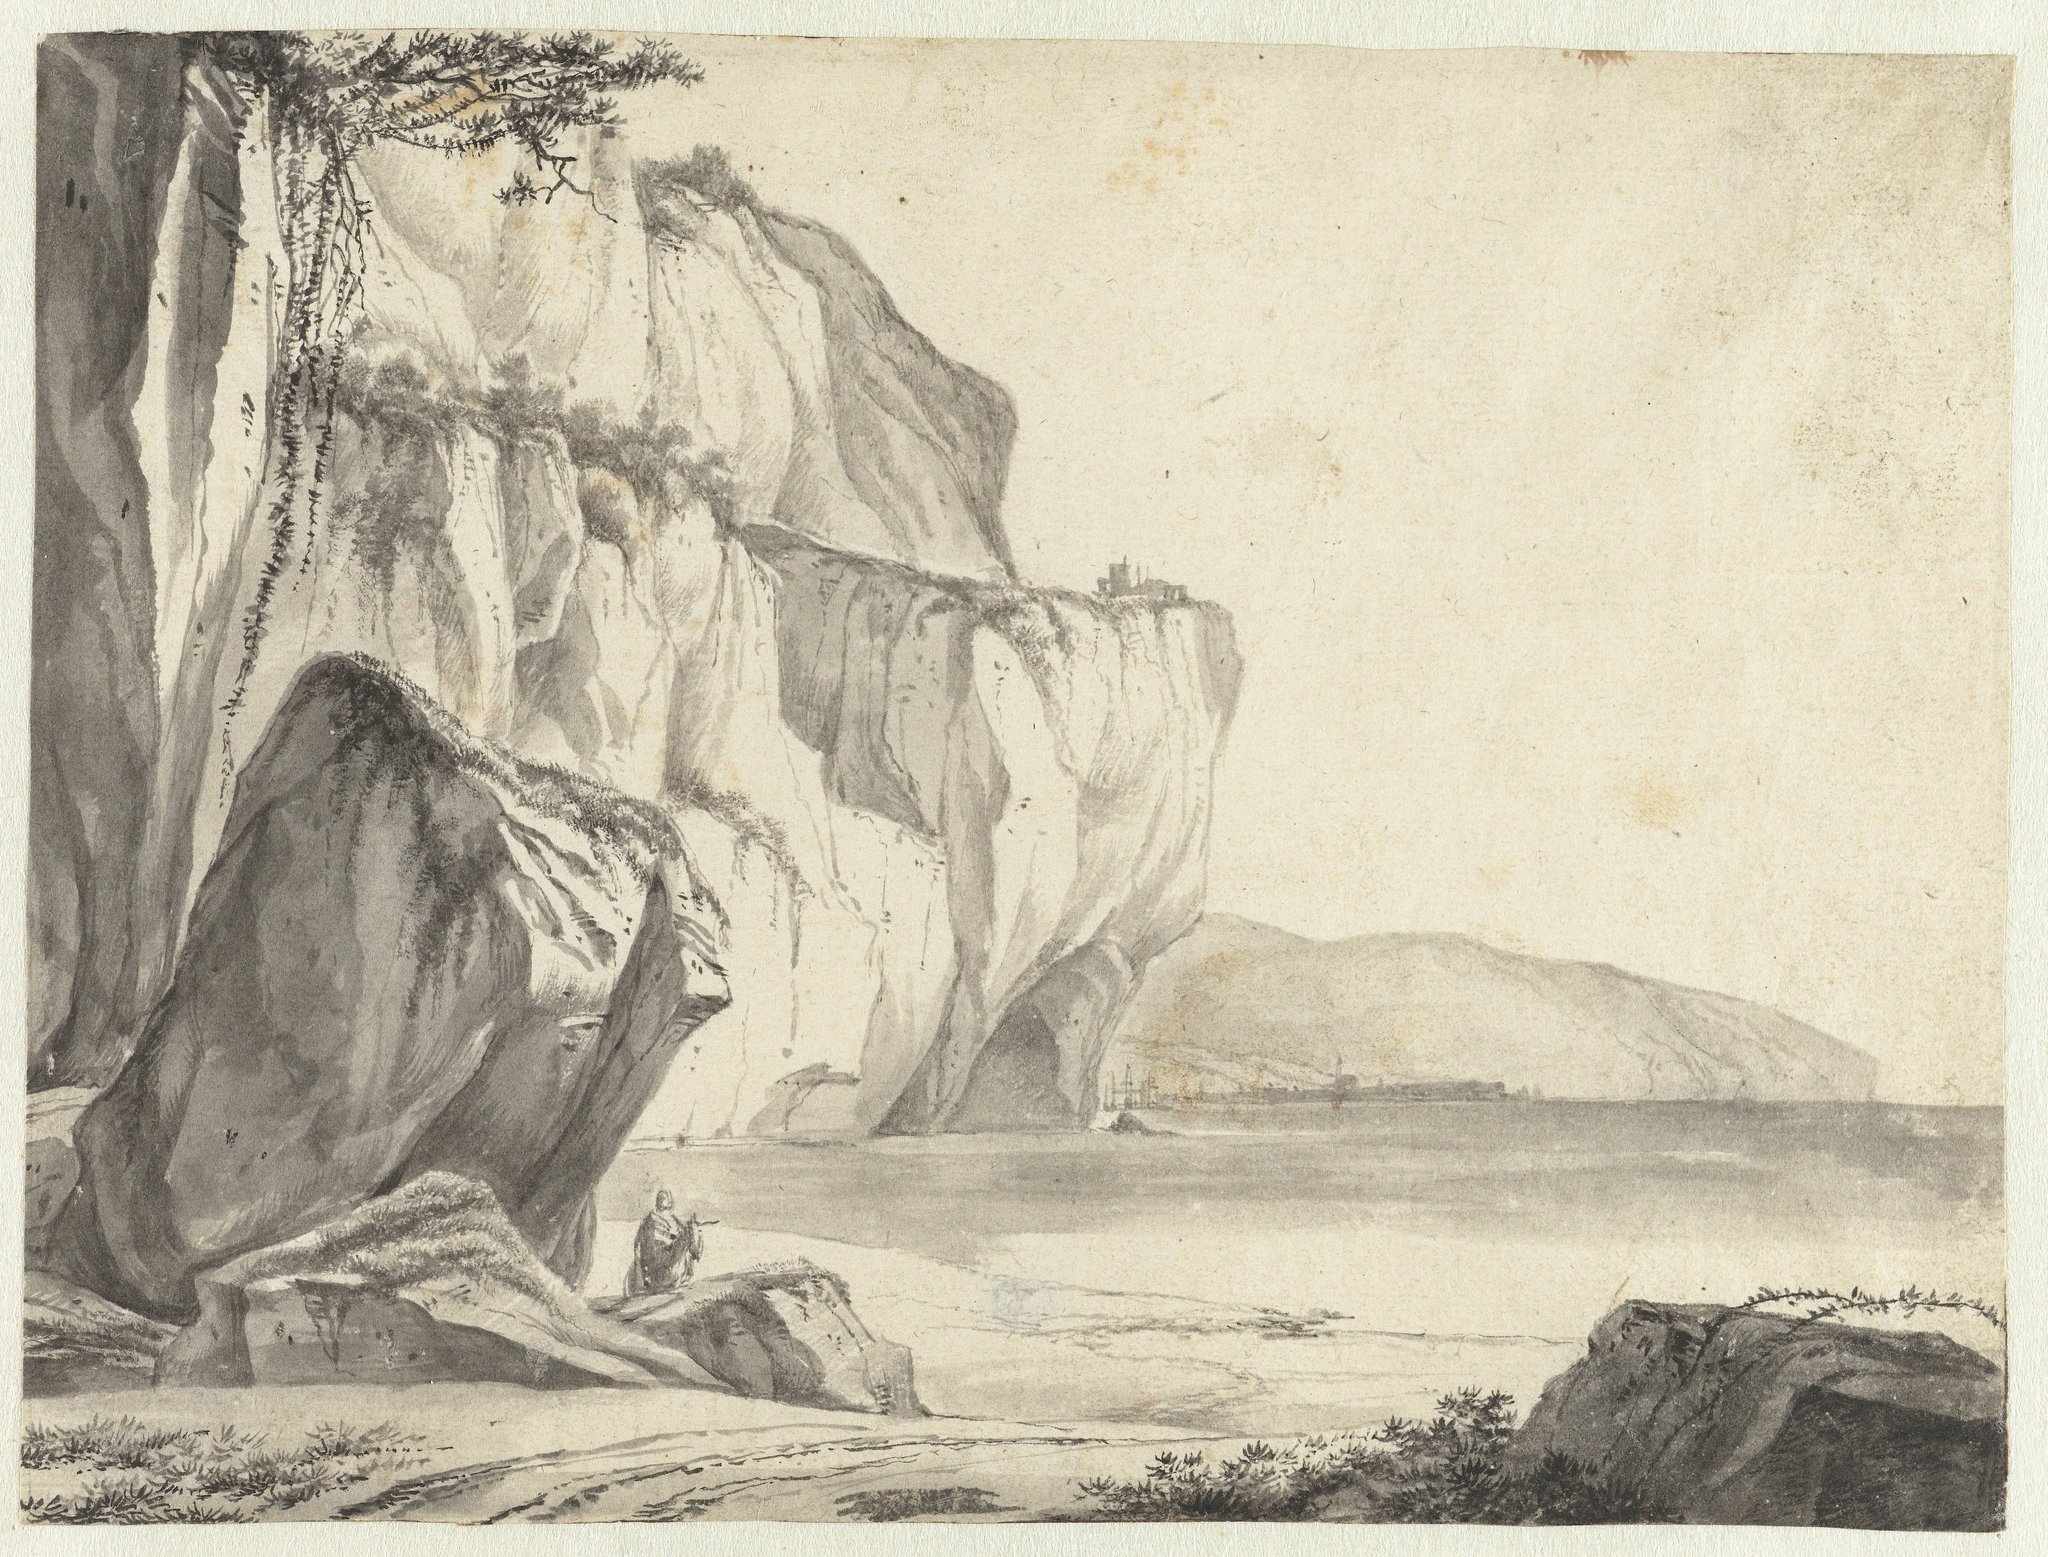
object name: drawing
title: Kustgezicht met uit het water oprijzende rotsen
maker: jan asselijn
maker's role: draughtsman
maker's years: 1610-1652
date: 1620-1652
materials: ink, paper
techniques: brush, pen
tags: rocky coast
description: Achter gesteente op de voorgrond is gedeeltelijk een muilezelberijder zichtbaar.